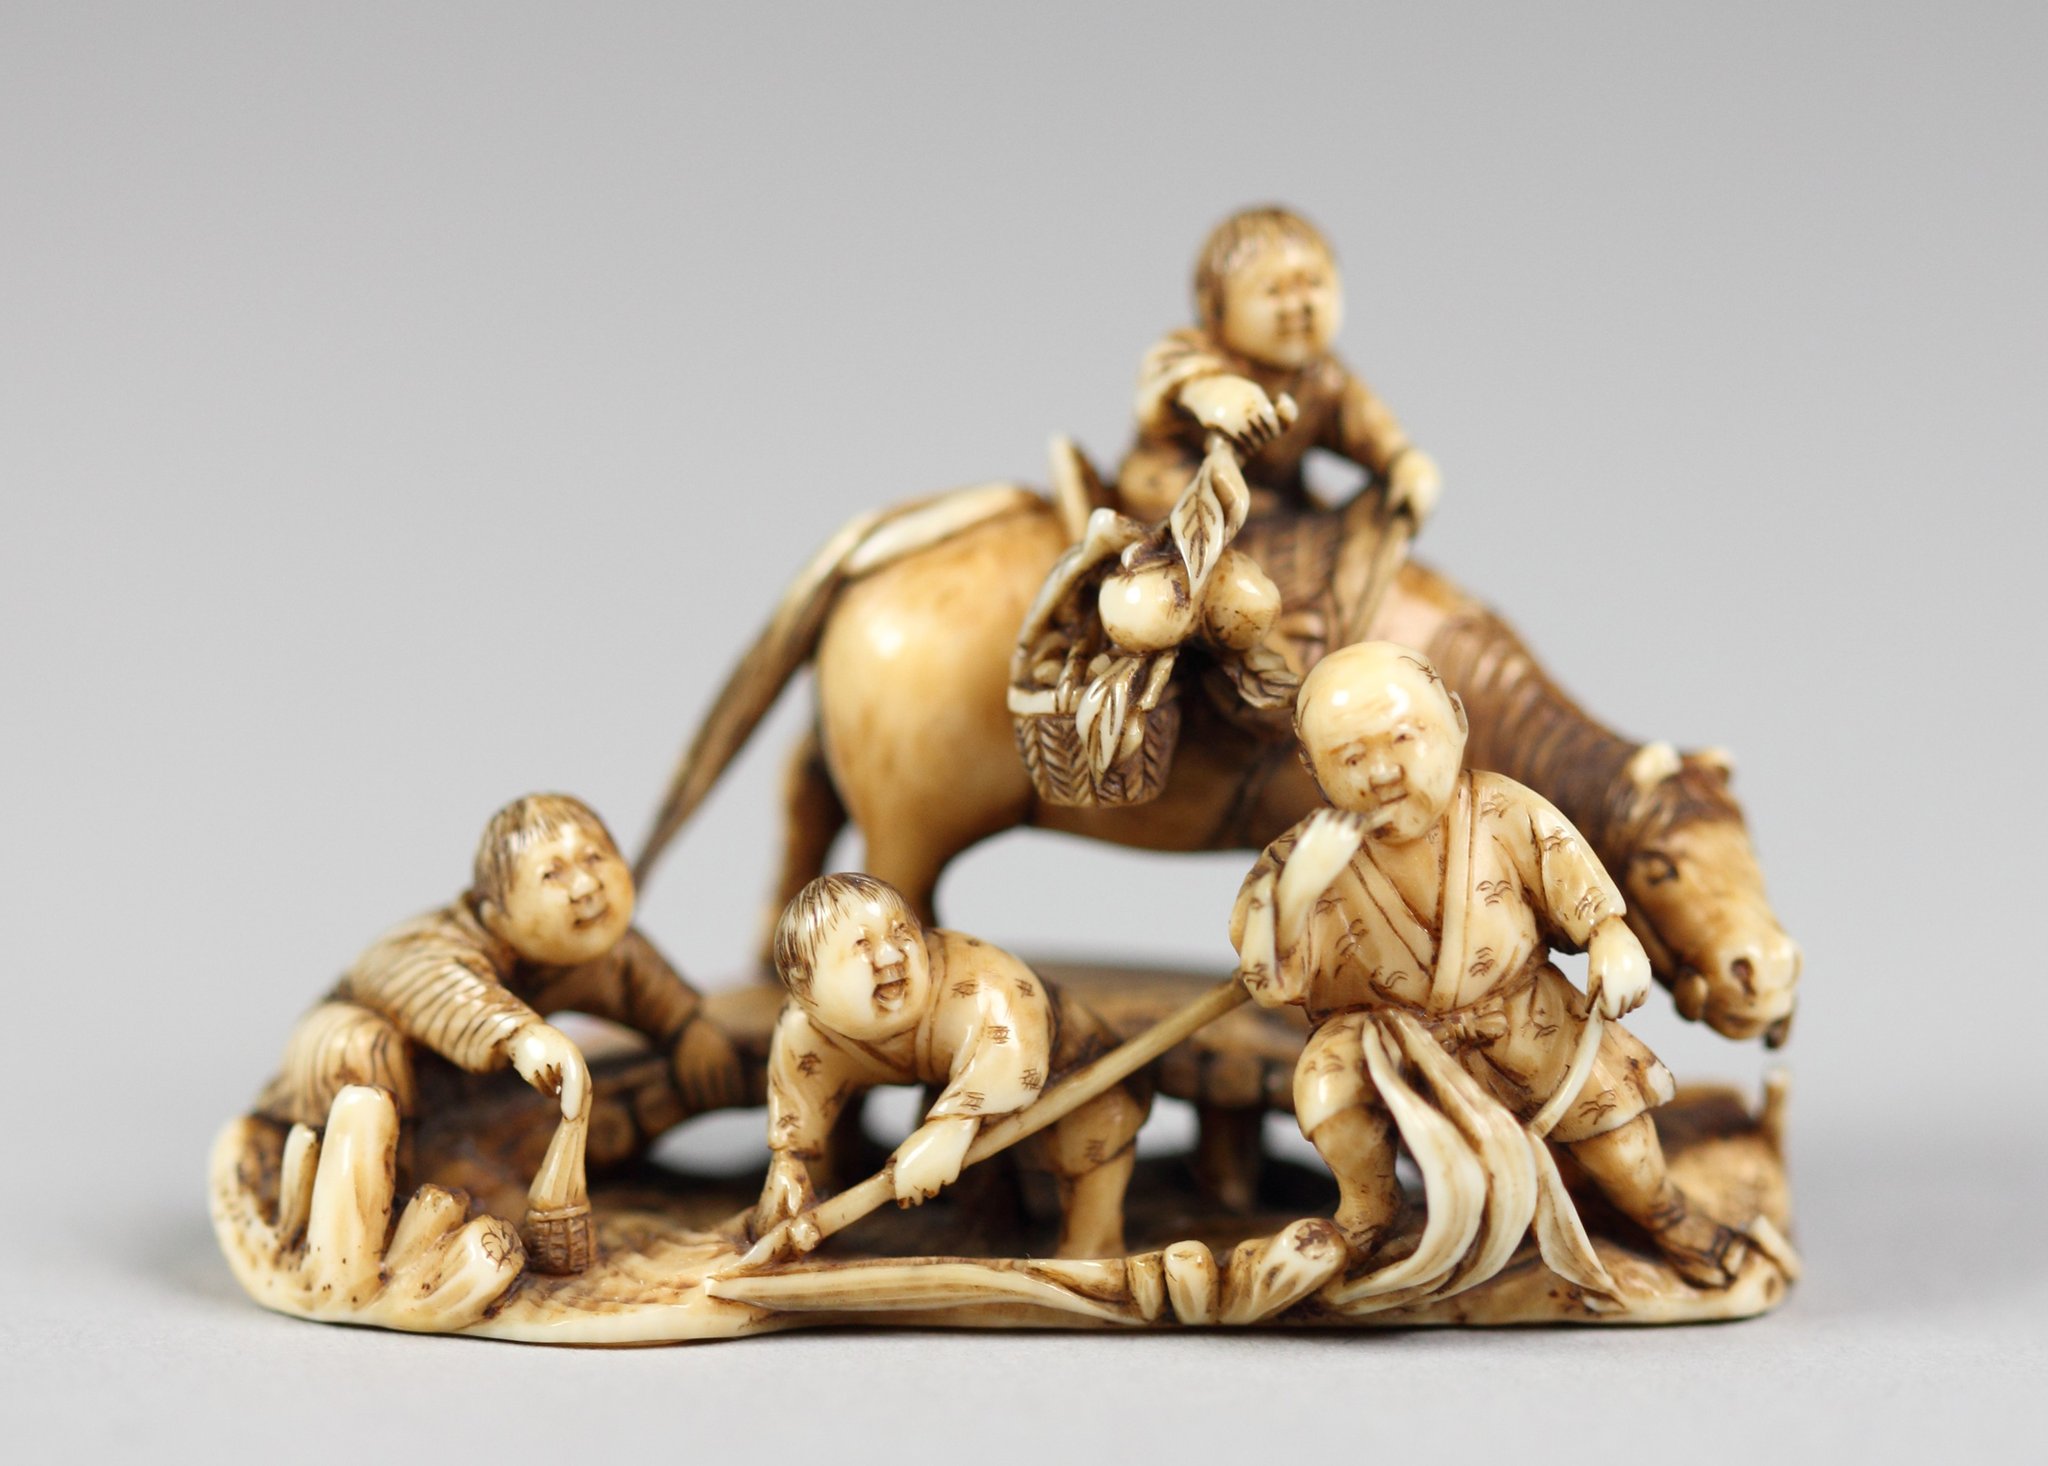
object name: netsuke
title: Netsuke of Group of Figures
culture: japanese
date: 1801-1900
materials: ivory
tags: horses